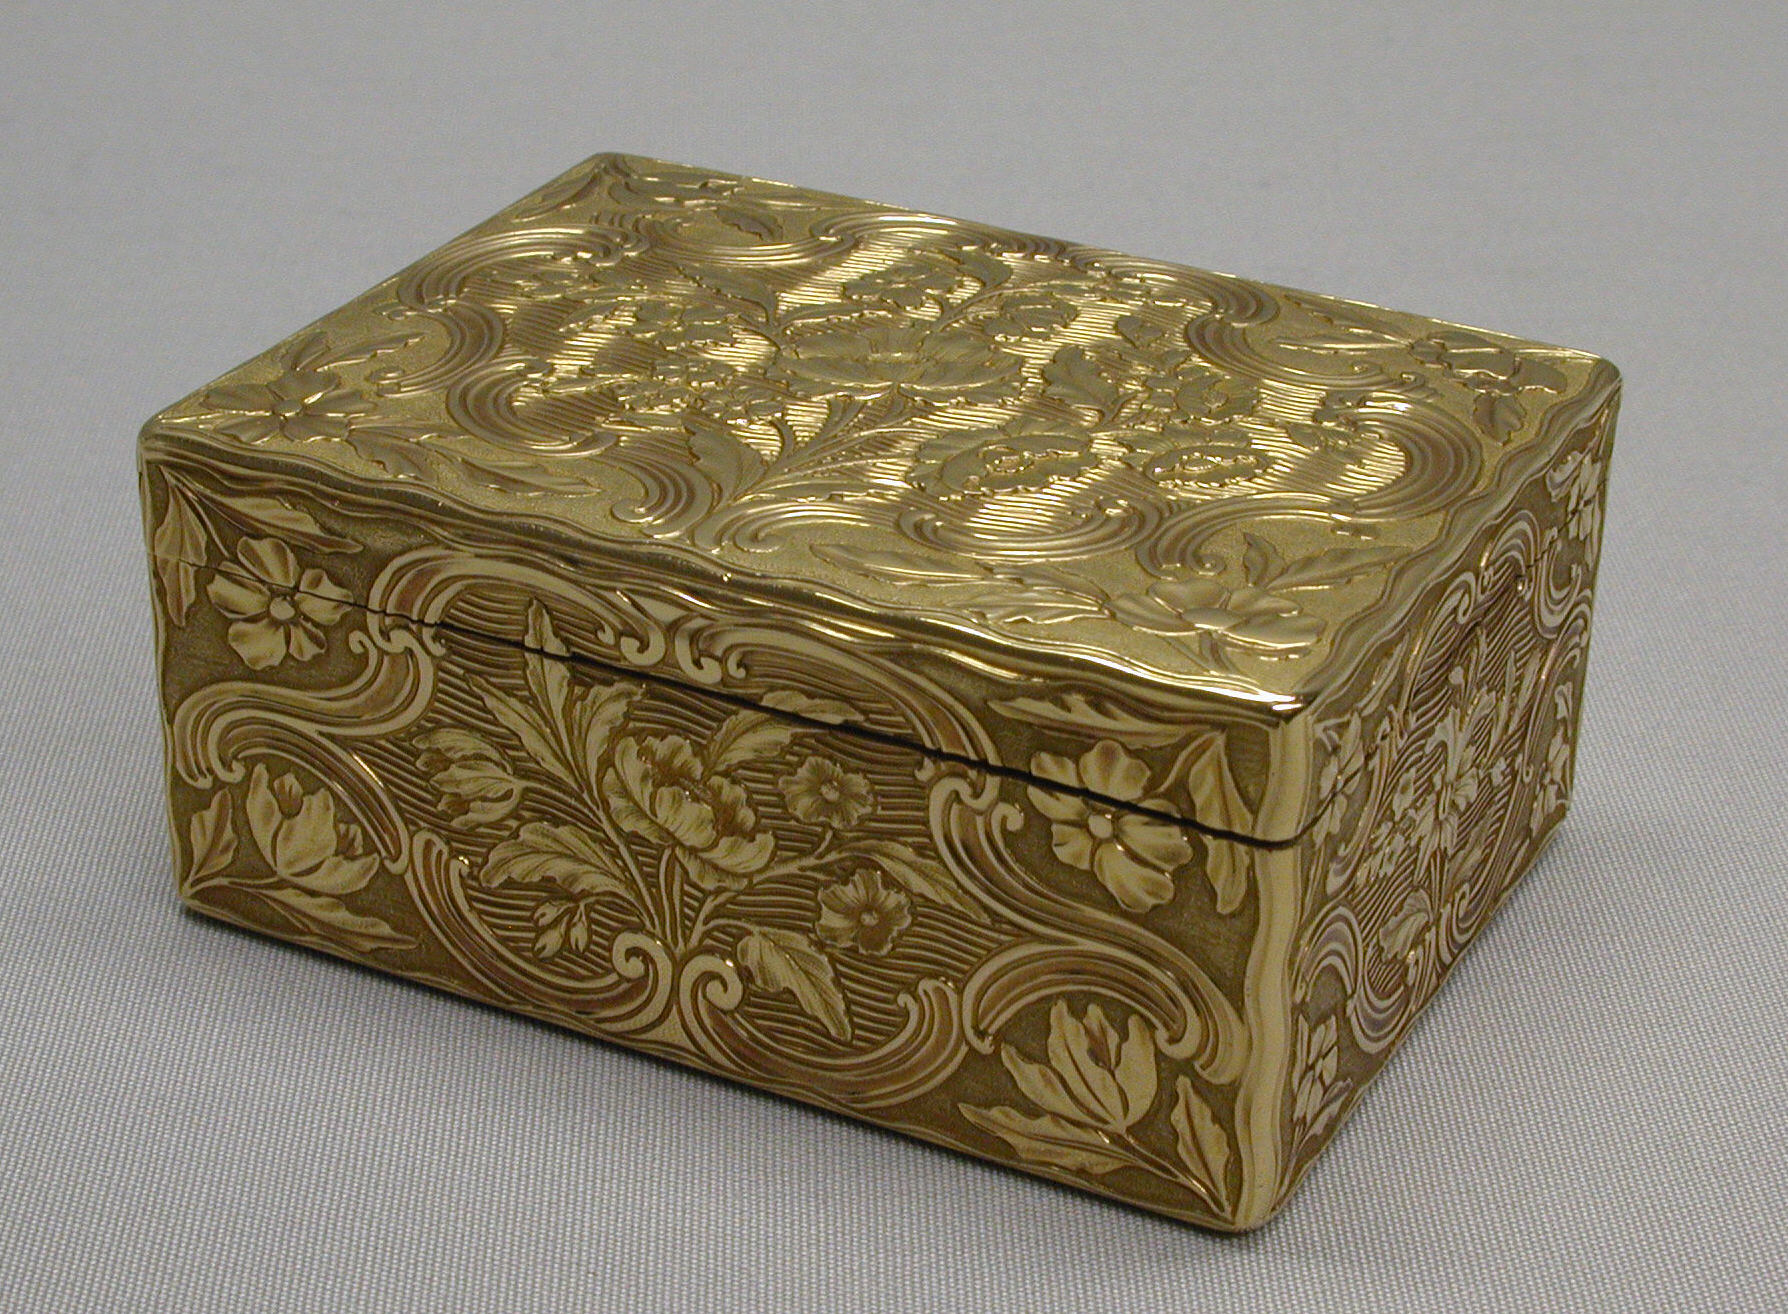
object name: snuffbox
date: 1749-1750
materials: gold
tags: flowers